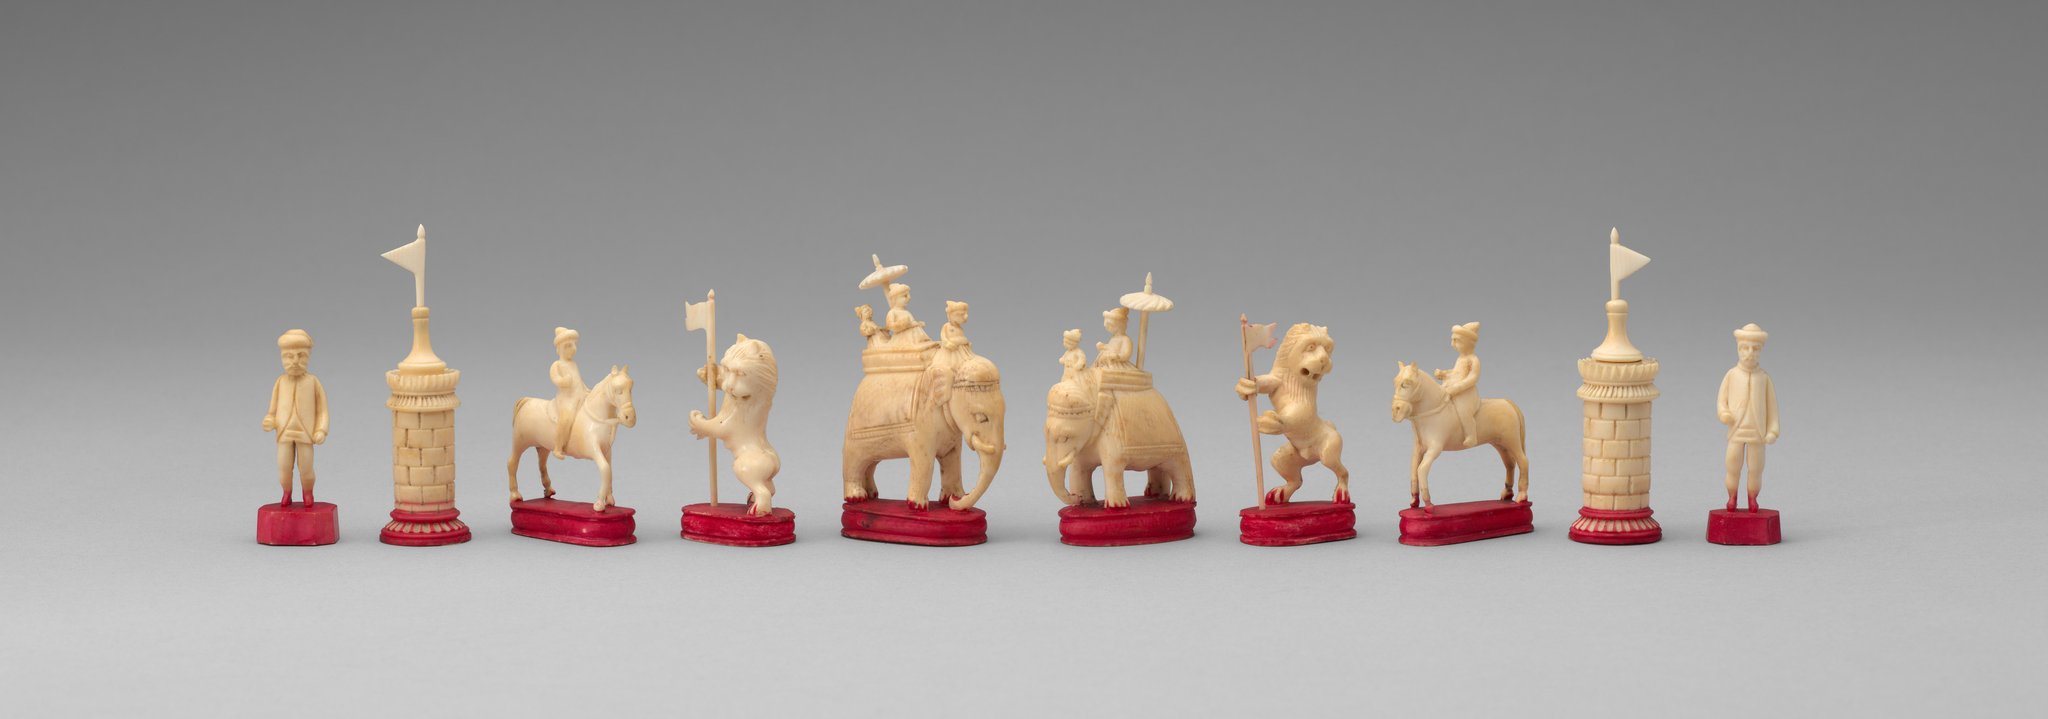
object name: chessman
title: Chessmen (32)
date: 1801-1900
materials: ivory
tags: chess,elephants,horses,lions